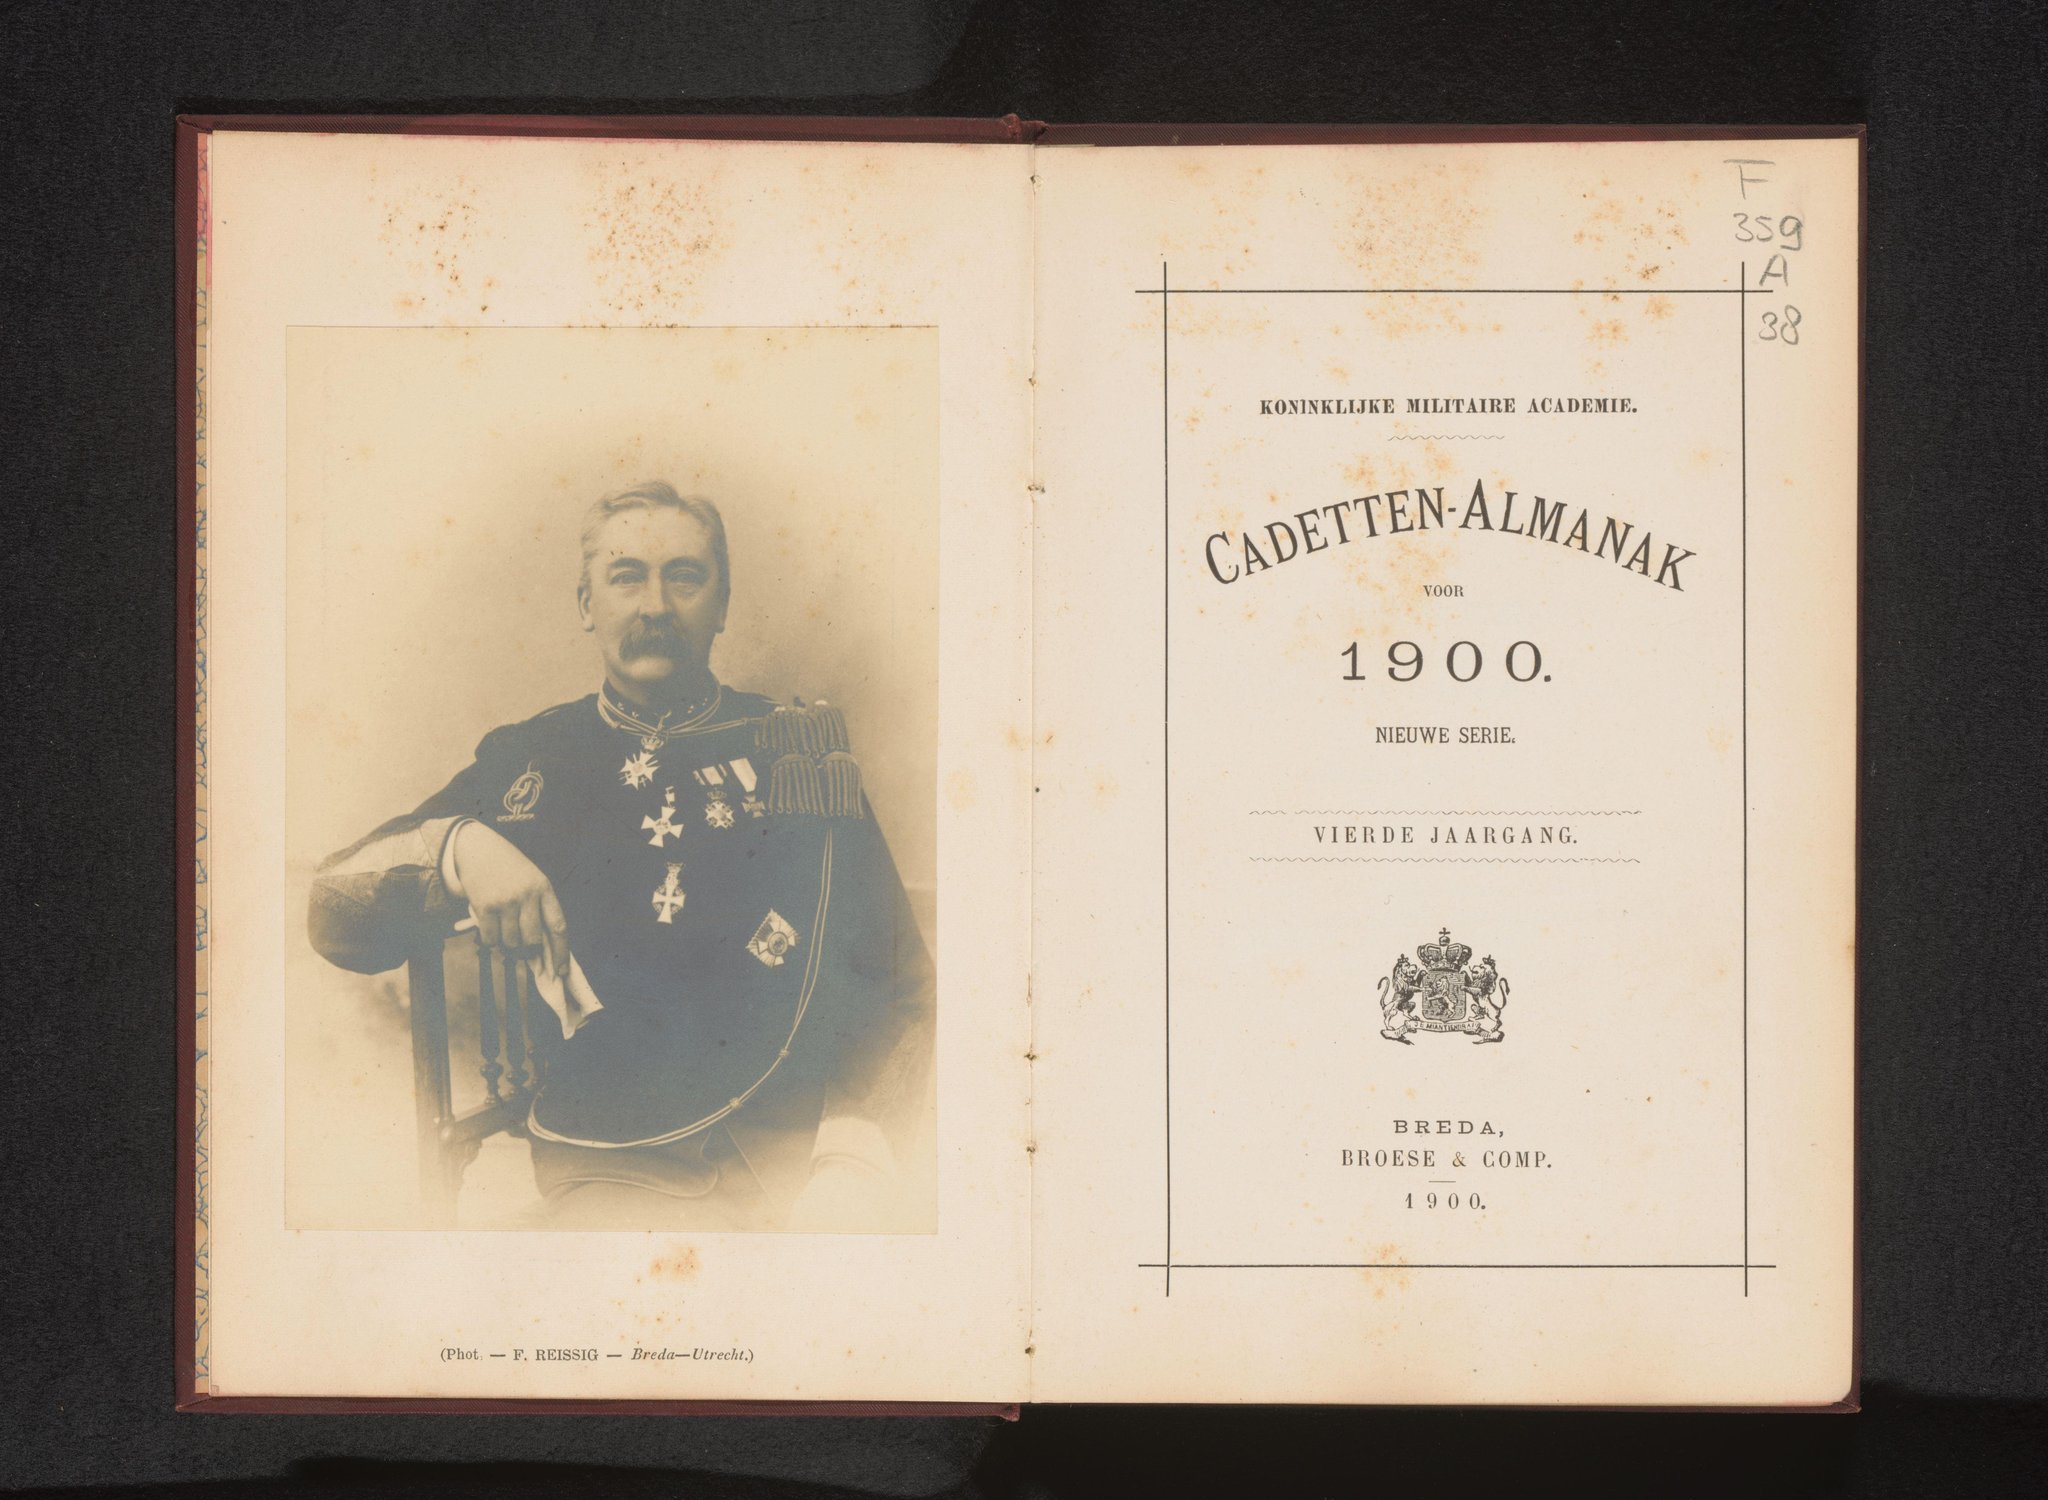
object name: book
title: Cadetten-almanak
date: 1900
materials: cardboard, linen, paper, photographic support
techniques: decorated paper, gelatin silver print, printing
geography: breda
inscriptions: name: ‘Storm de Grave/ C II 1899-1900.’